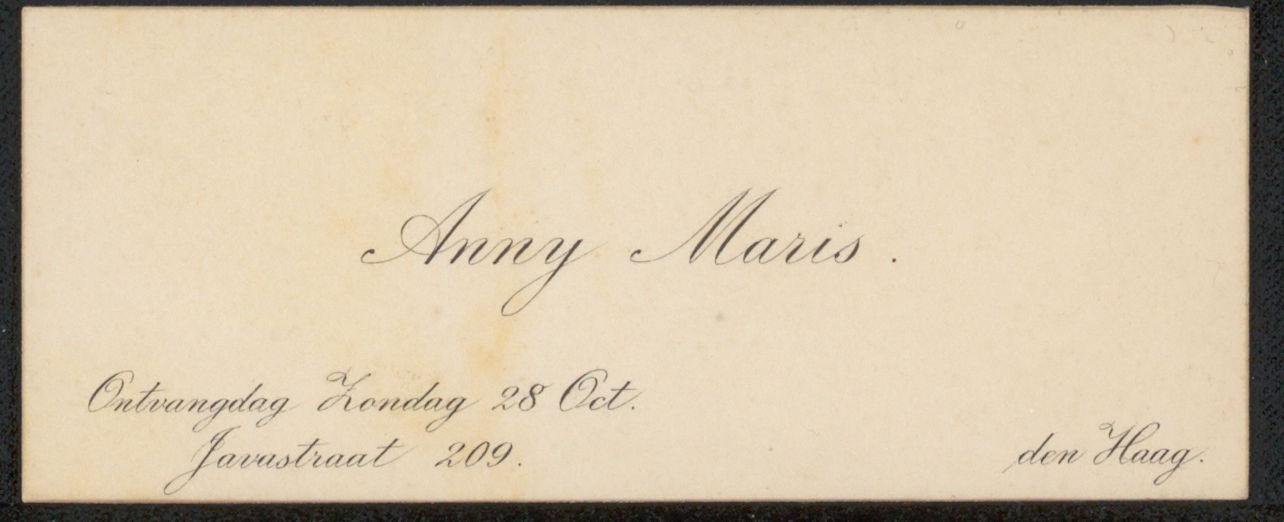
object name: visiting card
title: Visitekaartje aan Philip Zilcken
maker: annie maris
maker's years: 1875-1944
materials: cardboard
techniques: printing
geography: the hague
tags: painter, draughtsman, philip zilcken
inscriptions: collector's mark: ‘RPK’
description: Visitekaartje is samen met RP-D-1982-43-MARIS(ANNIE)-DOC.1B verstuurd in één envelop.